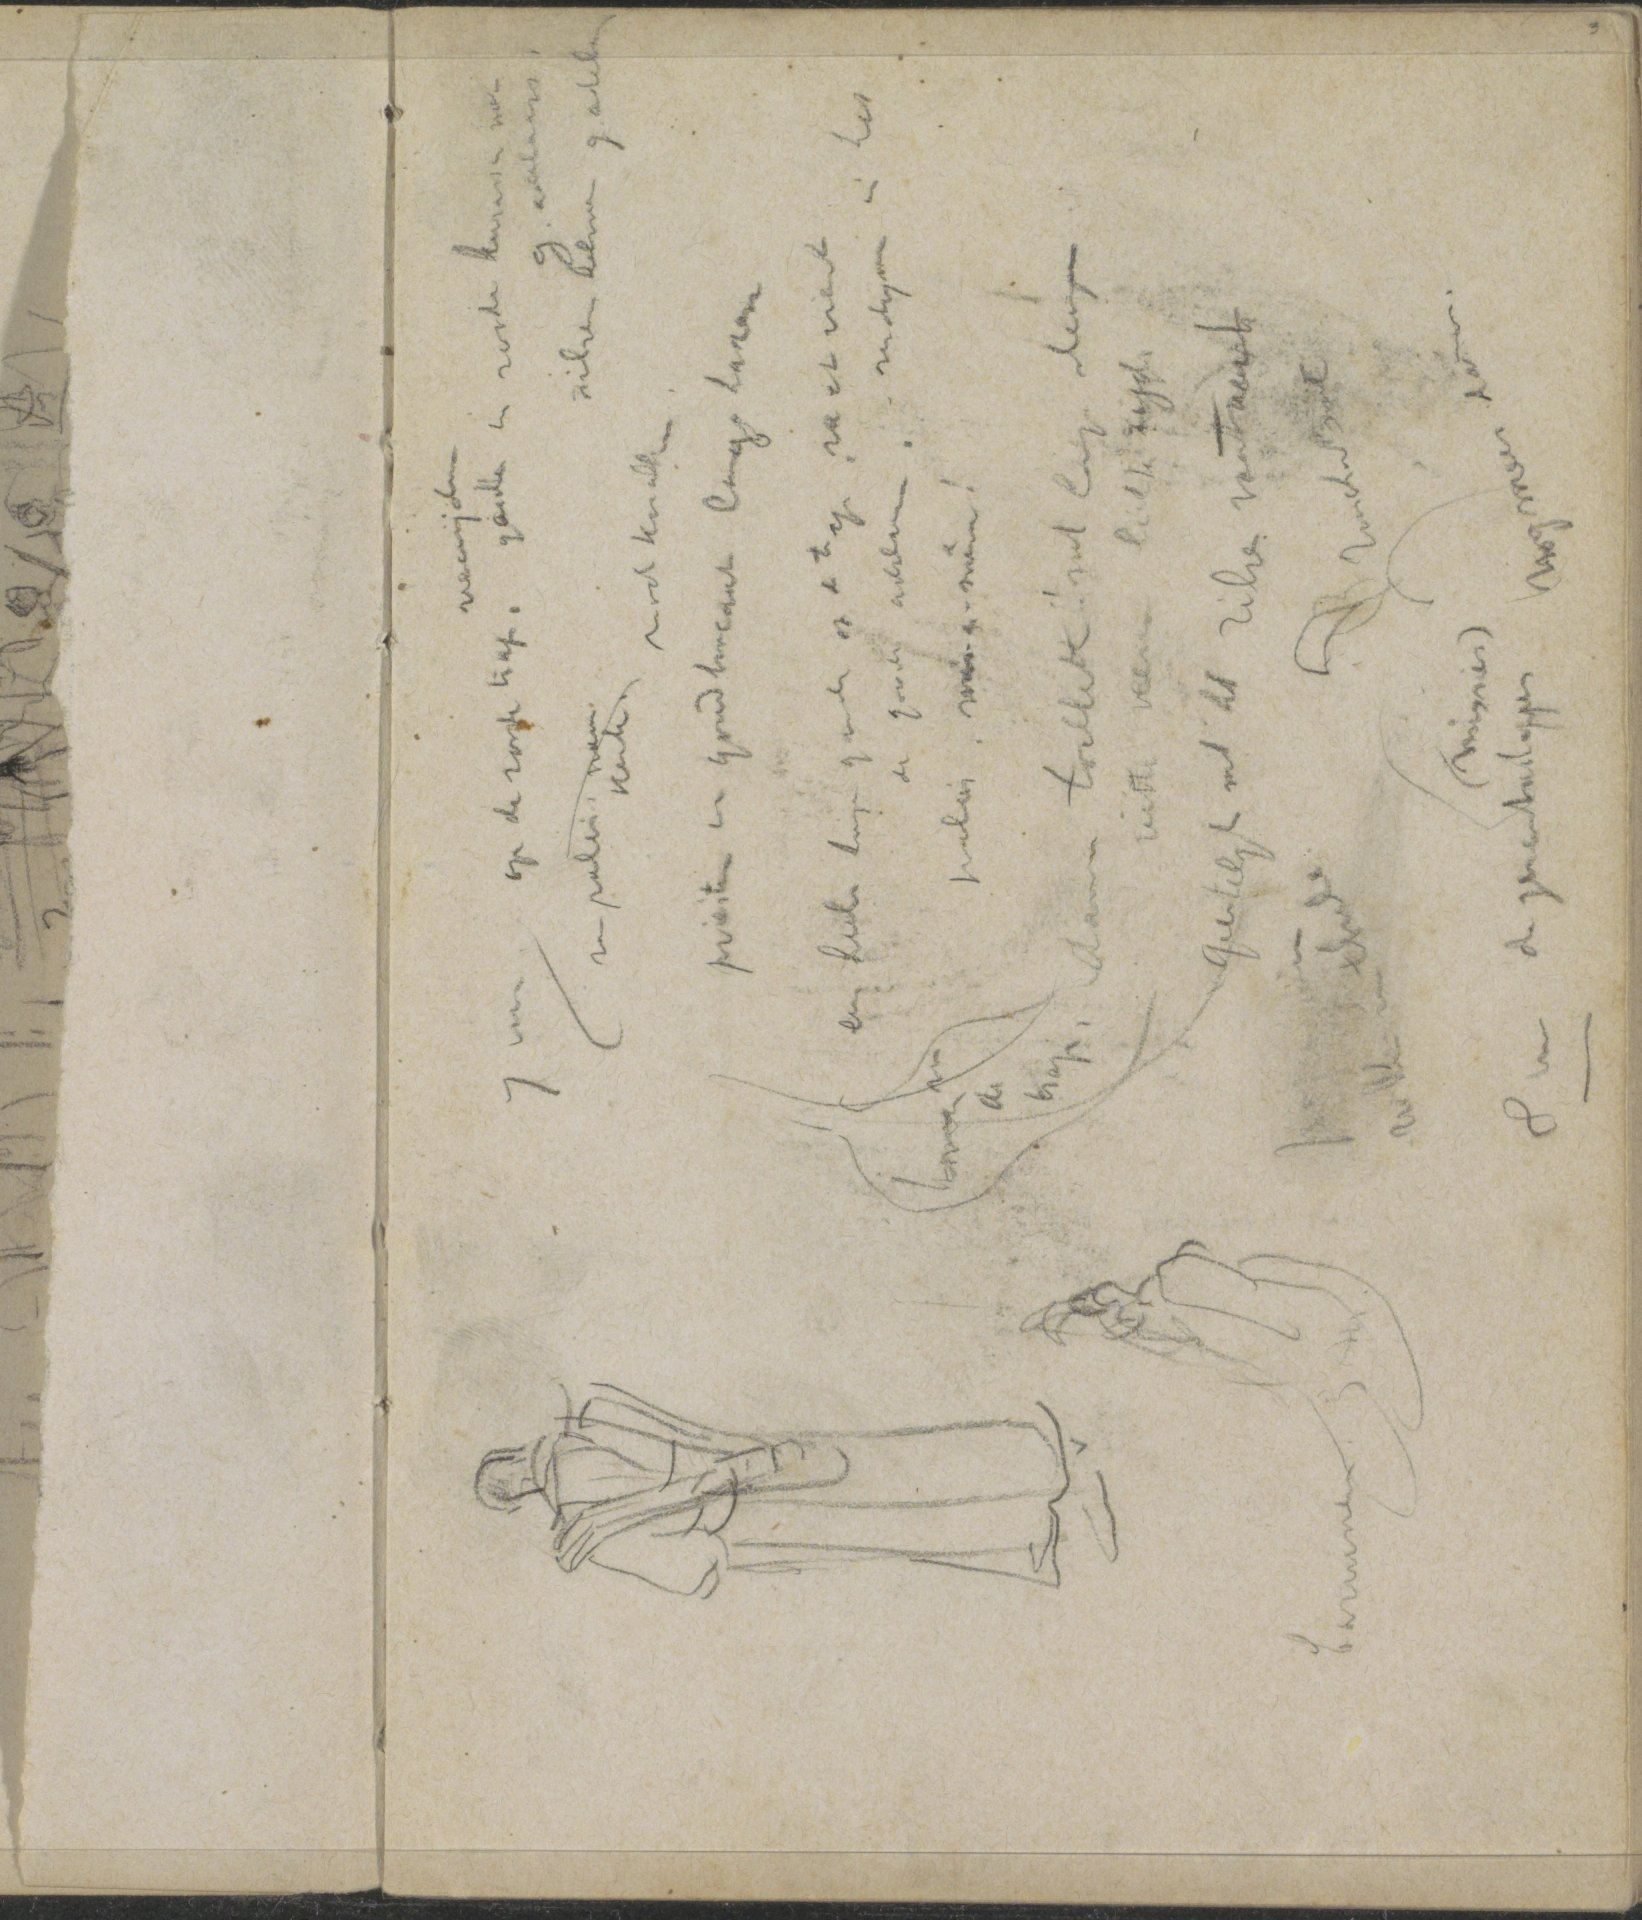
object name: sketchbook leaf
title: Figuur in kostuum, op de rug gezien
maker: marius bauer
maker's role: draughtsman, print maker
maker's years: 1867-1932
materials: chalk, paper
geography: moscow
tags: standing figure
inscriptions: annotation: ‘7 uur op de [...]/ van paleis naar/ kerk [...]’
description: Mogelijk draagt de figuur militair kostuum. Pagina 3 uit een schetsboek met 54 bladen.